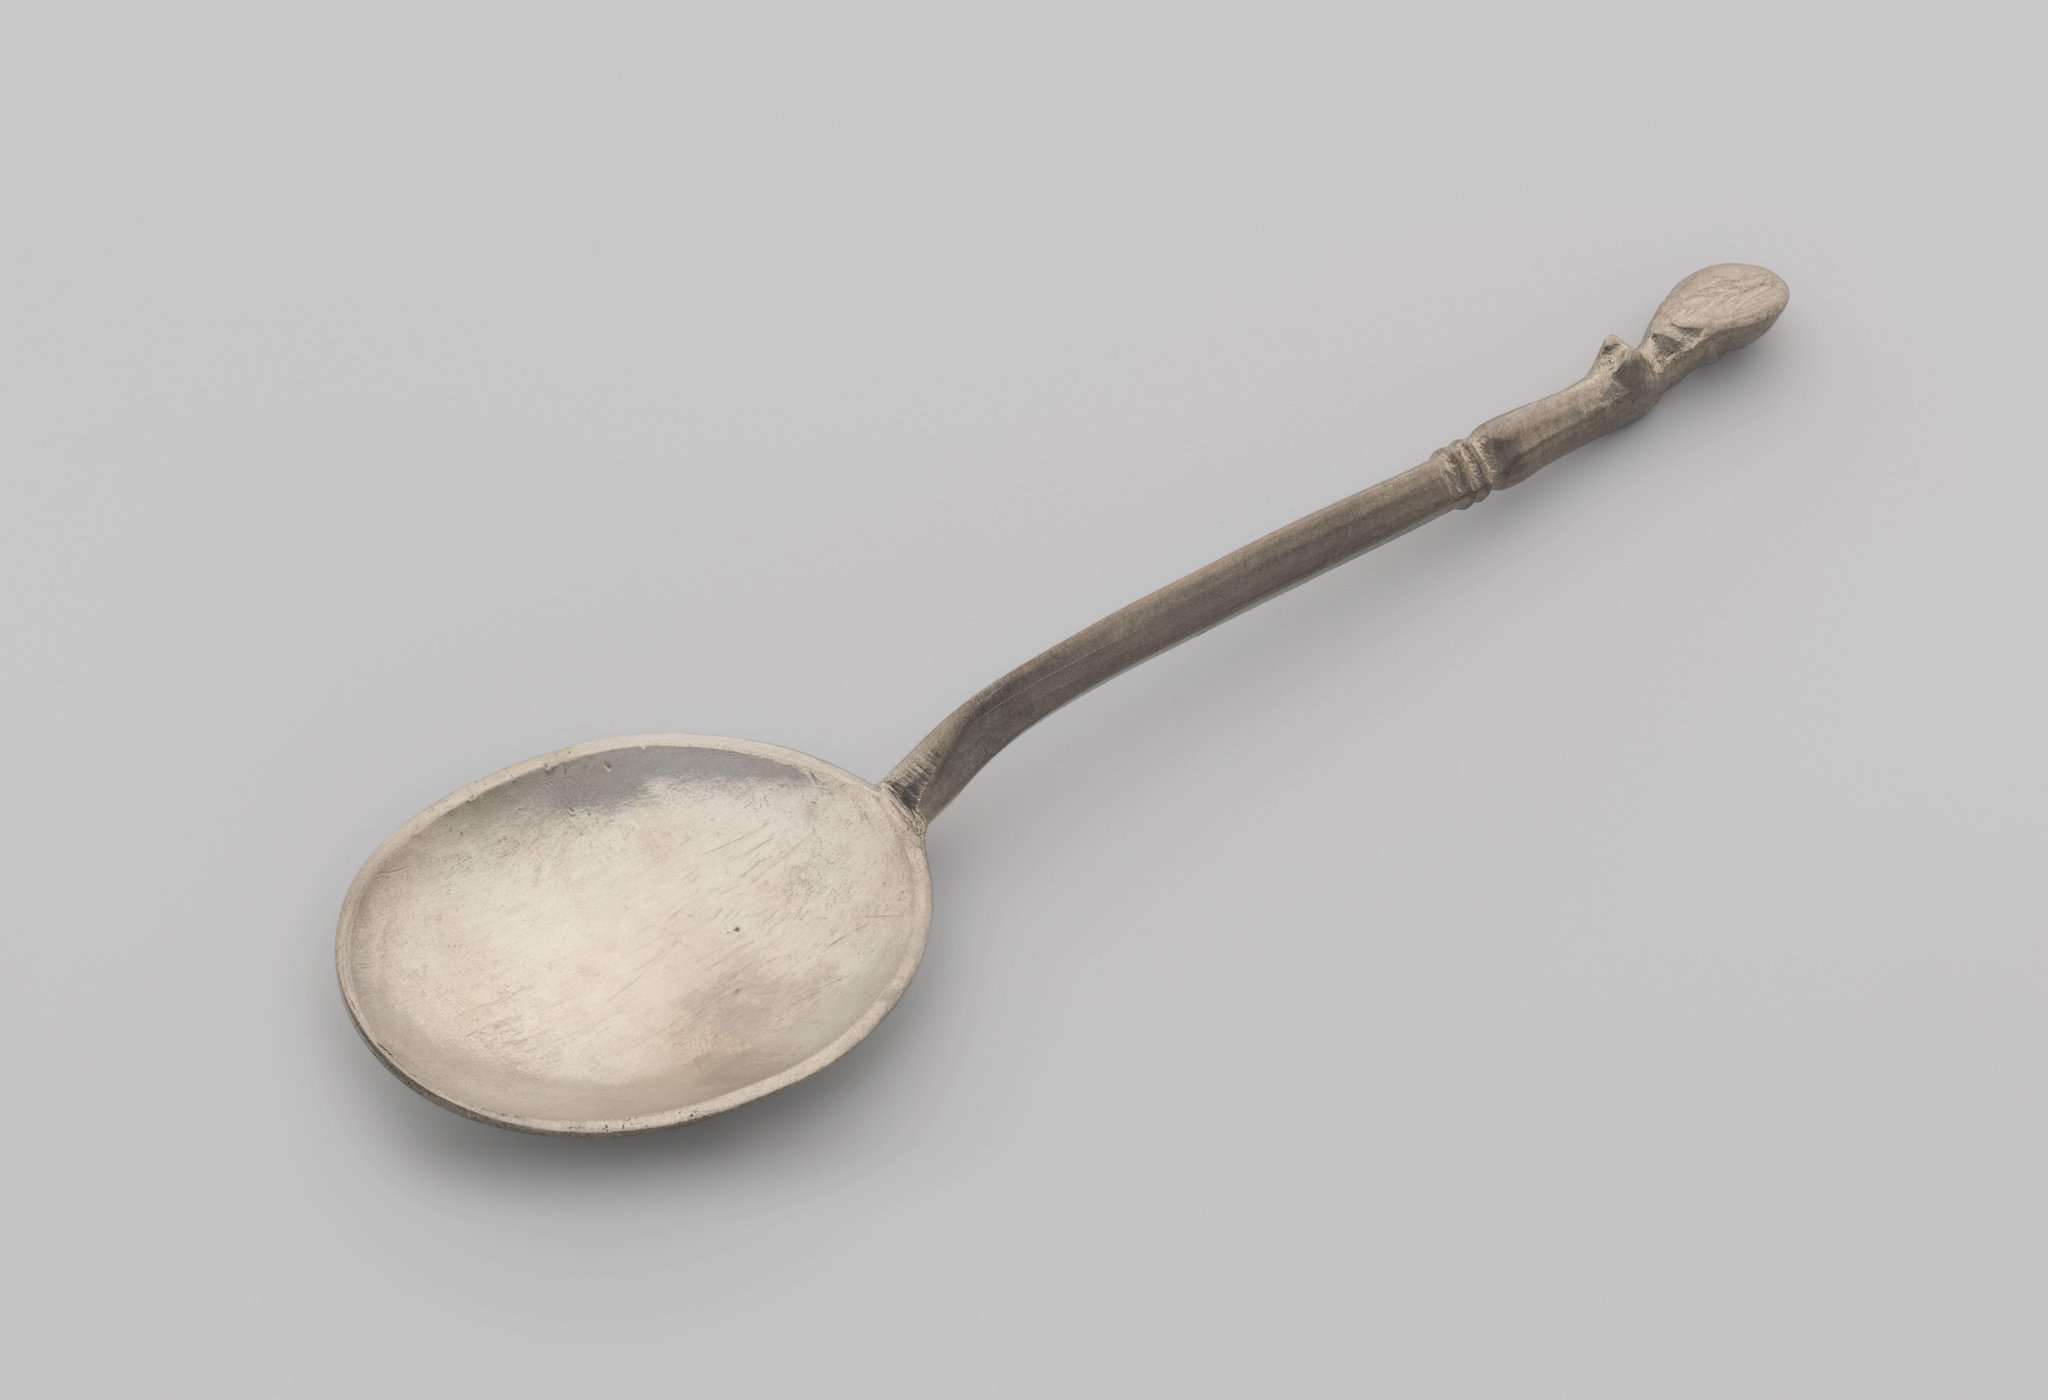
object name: spoon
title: Lepel van tin met paardenvoet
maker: Anonymous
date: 1500-1600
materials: tin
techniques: casting, turning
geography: low countries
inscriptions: quality mark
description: Tinnen lepel met gedraaide steel, die eindigt in een paardenvoet. Op de lepel een gekroonde roos als merk.